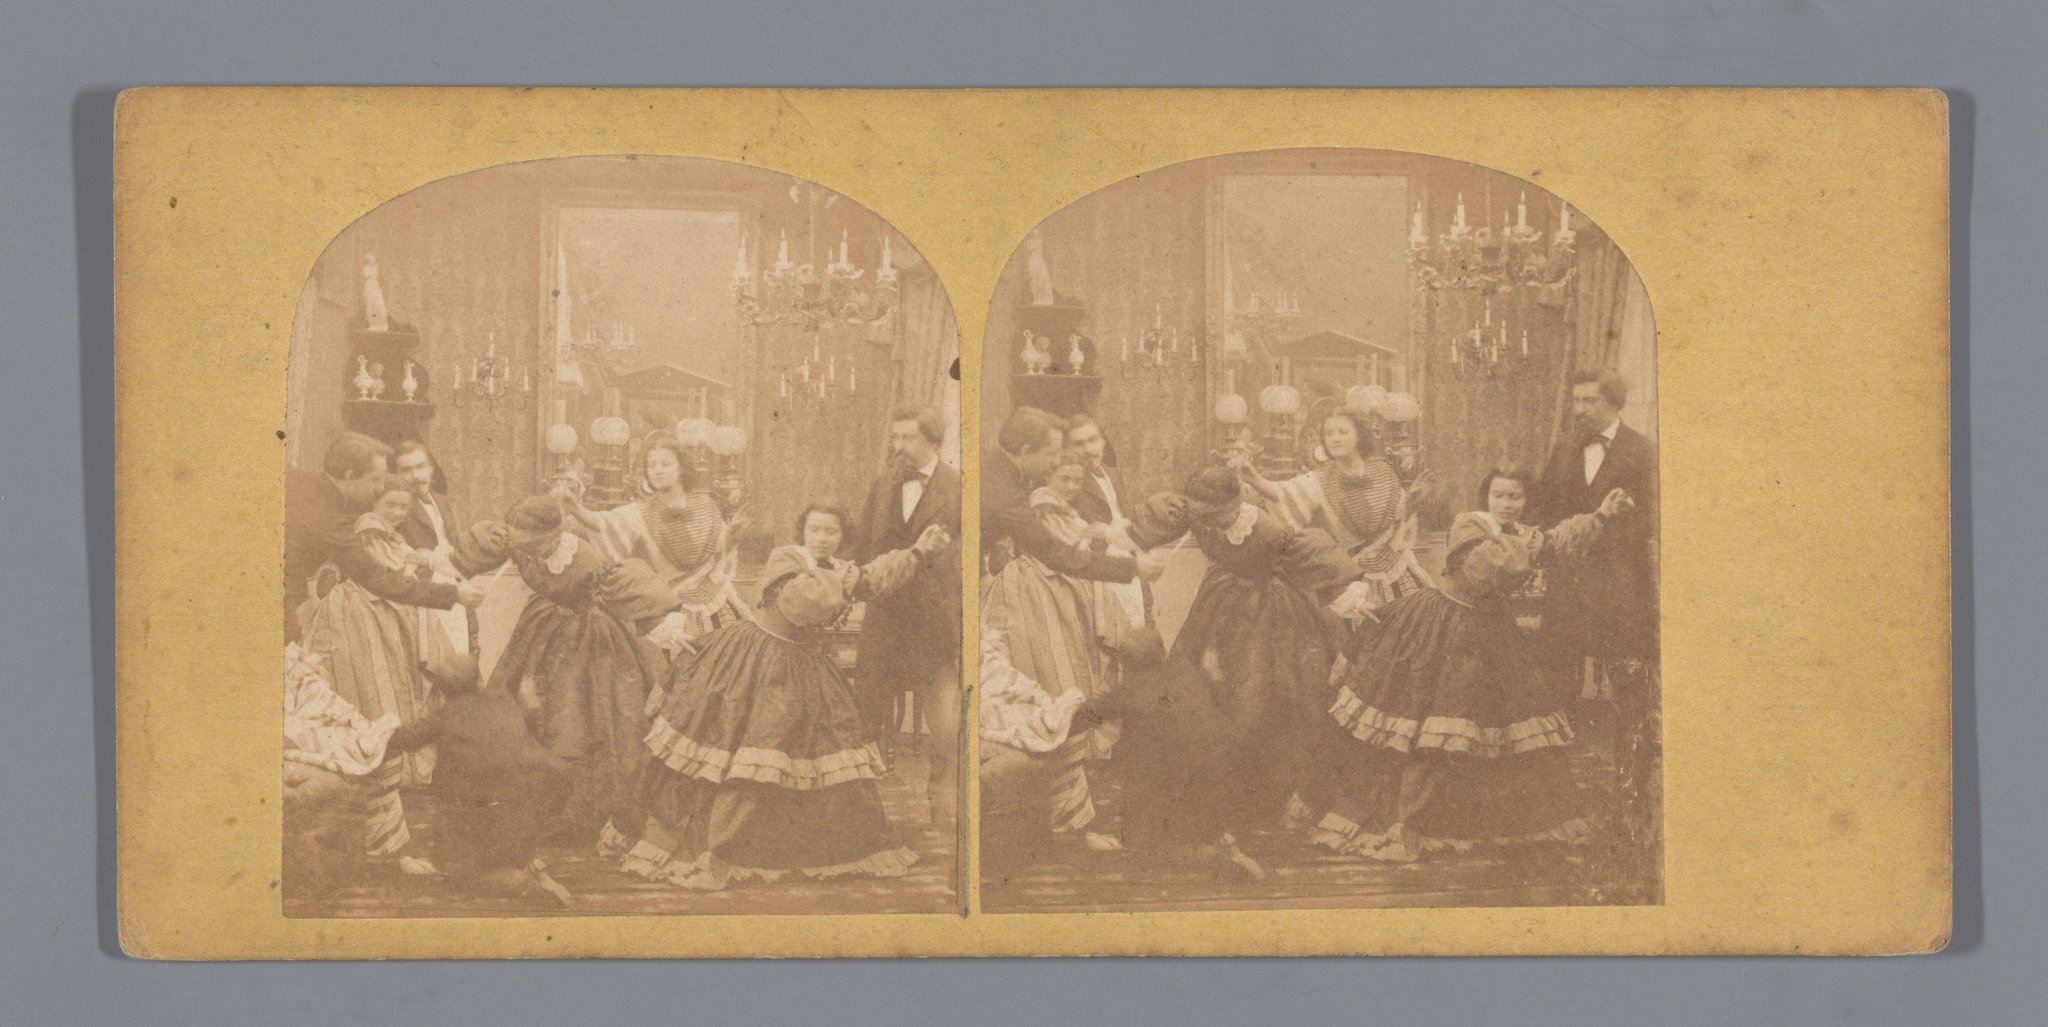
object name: stereograph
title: Gezelschap speelt een spel met een blinddoek in een kamer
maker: Anonymous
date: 1850-1880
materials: cardboard, photographic support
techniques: albumen print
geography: europe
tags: blindfold games, europe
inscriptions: number: ‘30’, number: ‘N 18’